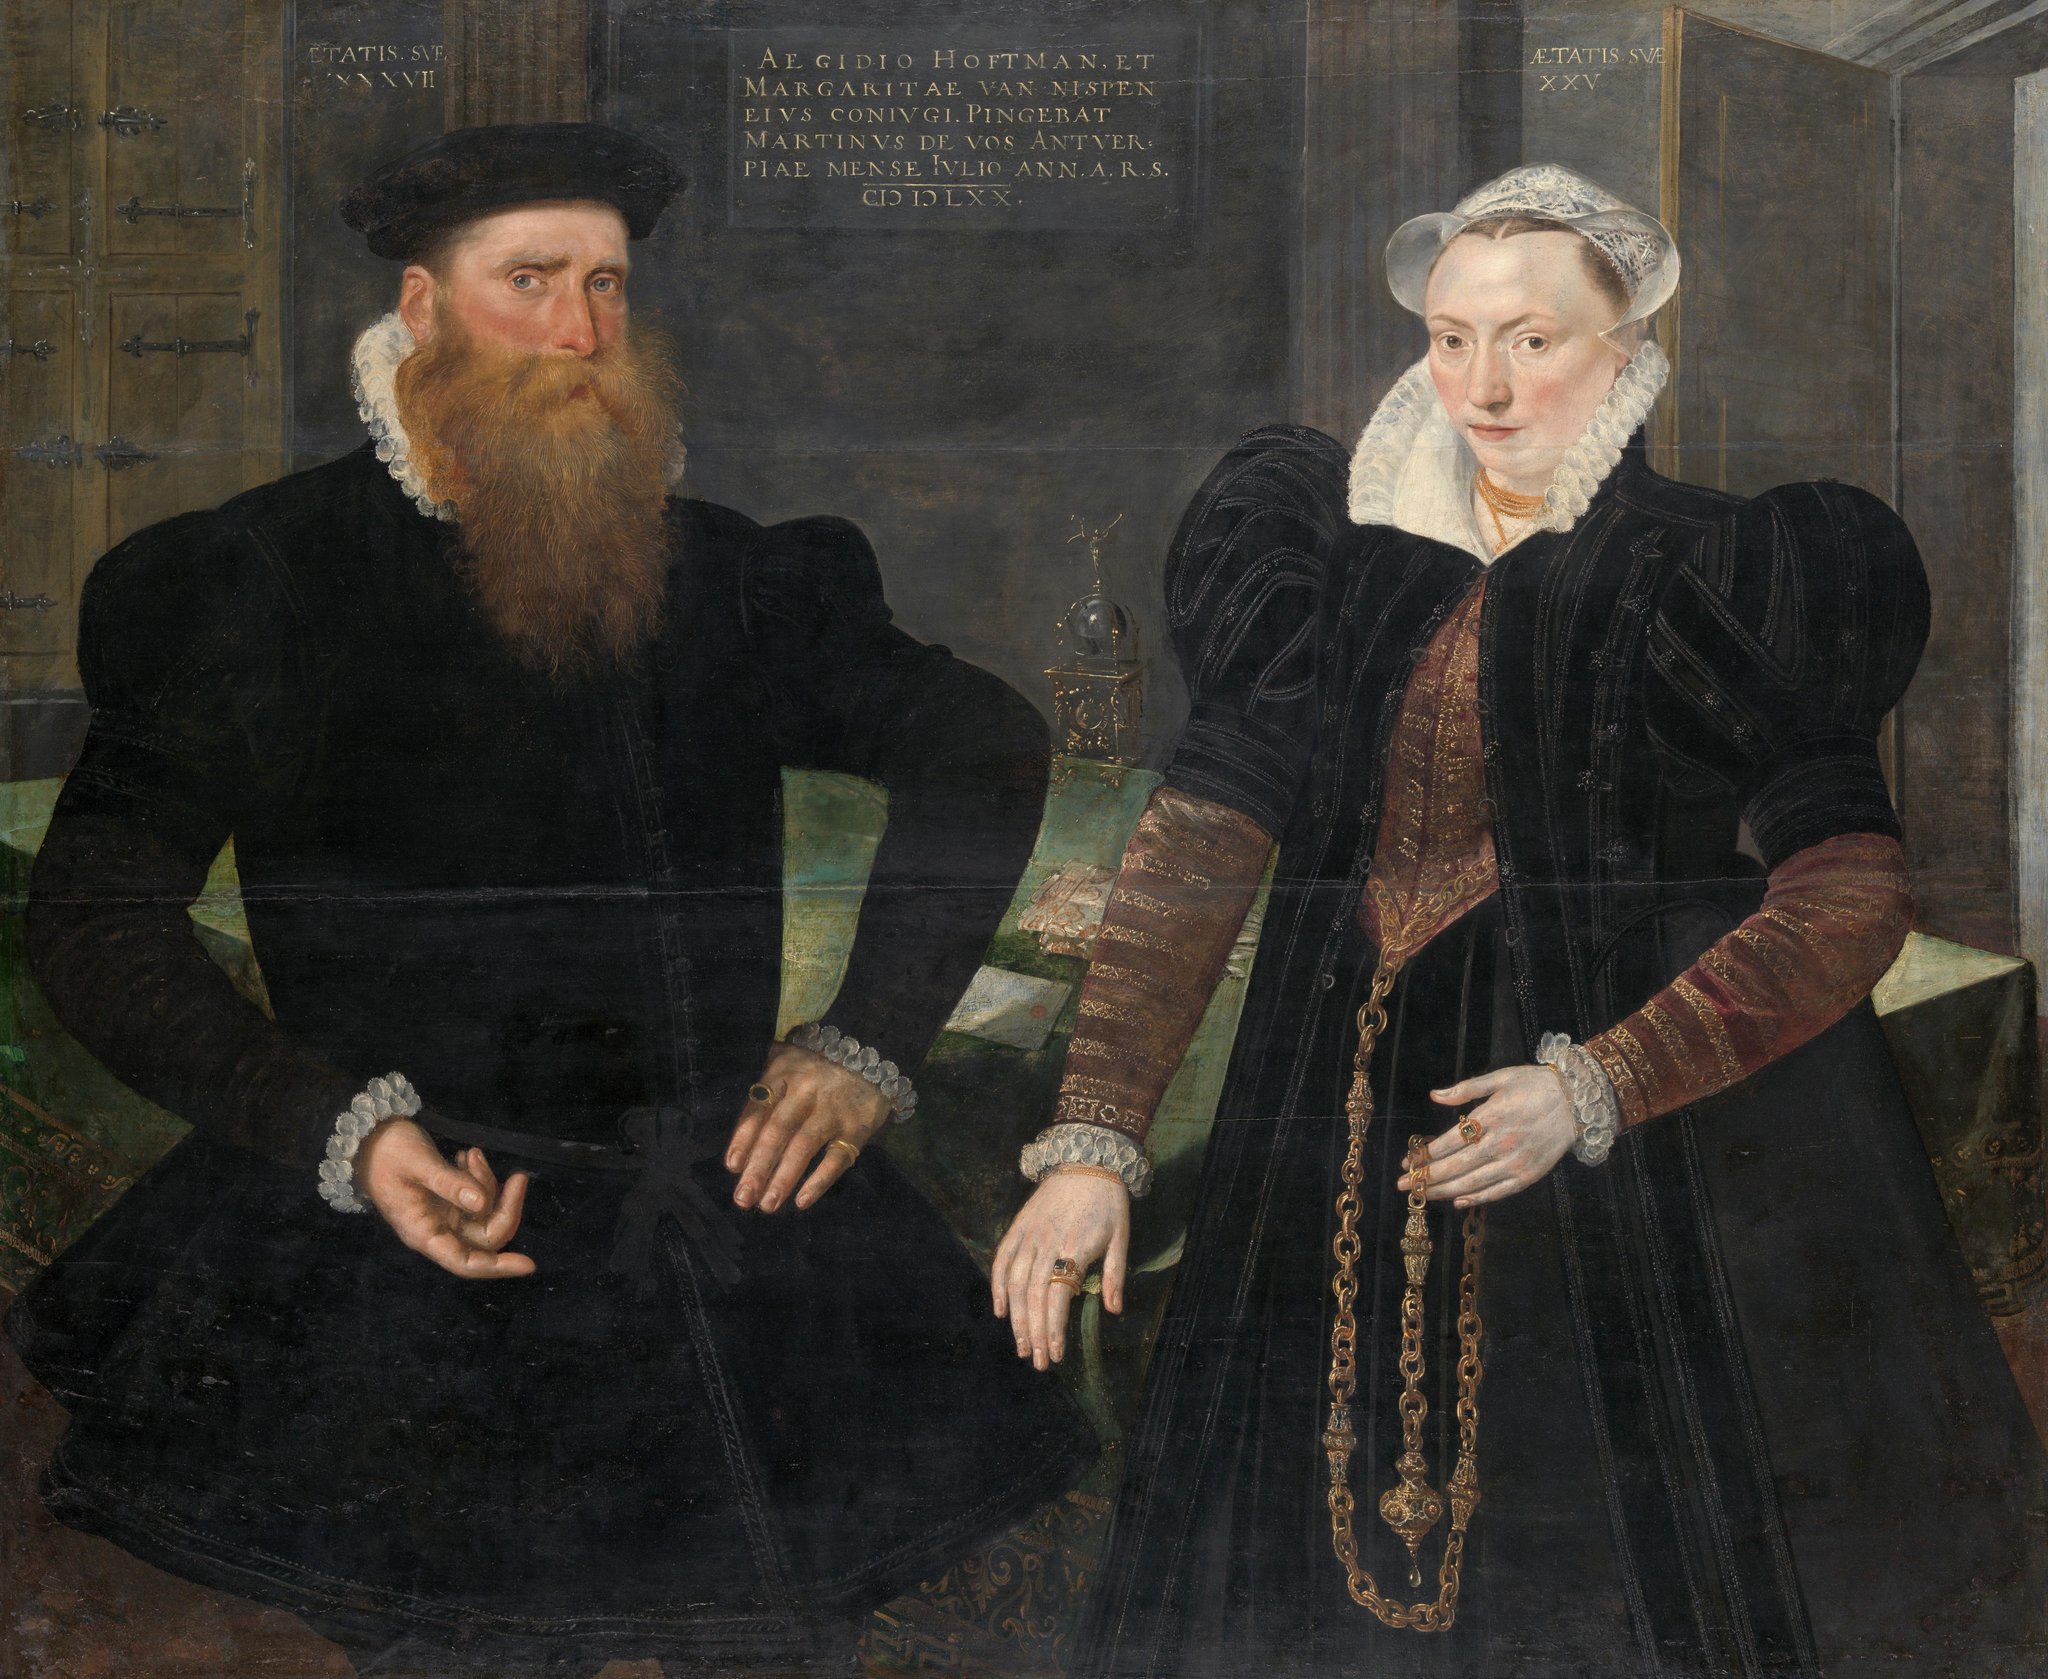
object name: painting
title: Portrait of Gillis Hooftman, Shipowner, and his Wife Margaretha van Nispen (Gilles van Eichelenberg, called Hoffman)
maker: maerten de vos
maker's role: draughtsman, painter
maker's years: 1532-1603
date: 1507-1570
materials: oil, panel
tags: historical persons - bb - woman, historical persons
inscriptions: signature, date and inscription, top centre: ‘Aetatis. Sue. XXXXVII / Aegidio Hoftman et Margaritae van Nispen eius coniugi pingebat Martinus De Vos Antverpiae mense Iulio ann. A.R.S. MDLXX. / Aetatis suae. XXV’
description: Portret van de reder Gillis Hooftman (1521-81) met zijn echtgenote Margaretha van Nispen (geb. 1545). Kniestuk, beiden staande in een kamer voor een tafel waarop een klok, handschoenen en een brief liggen.